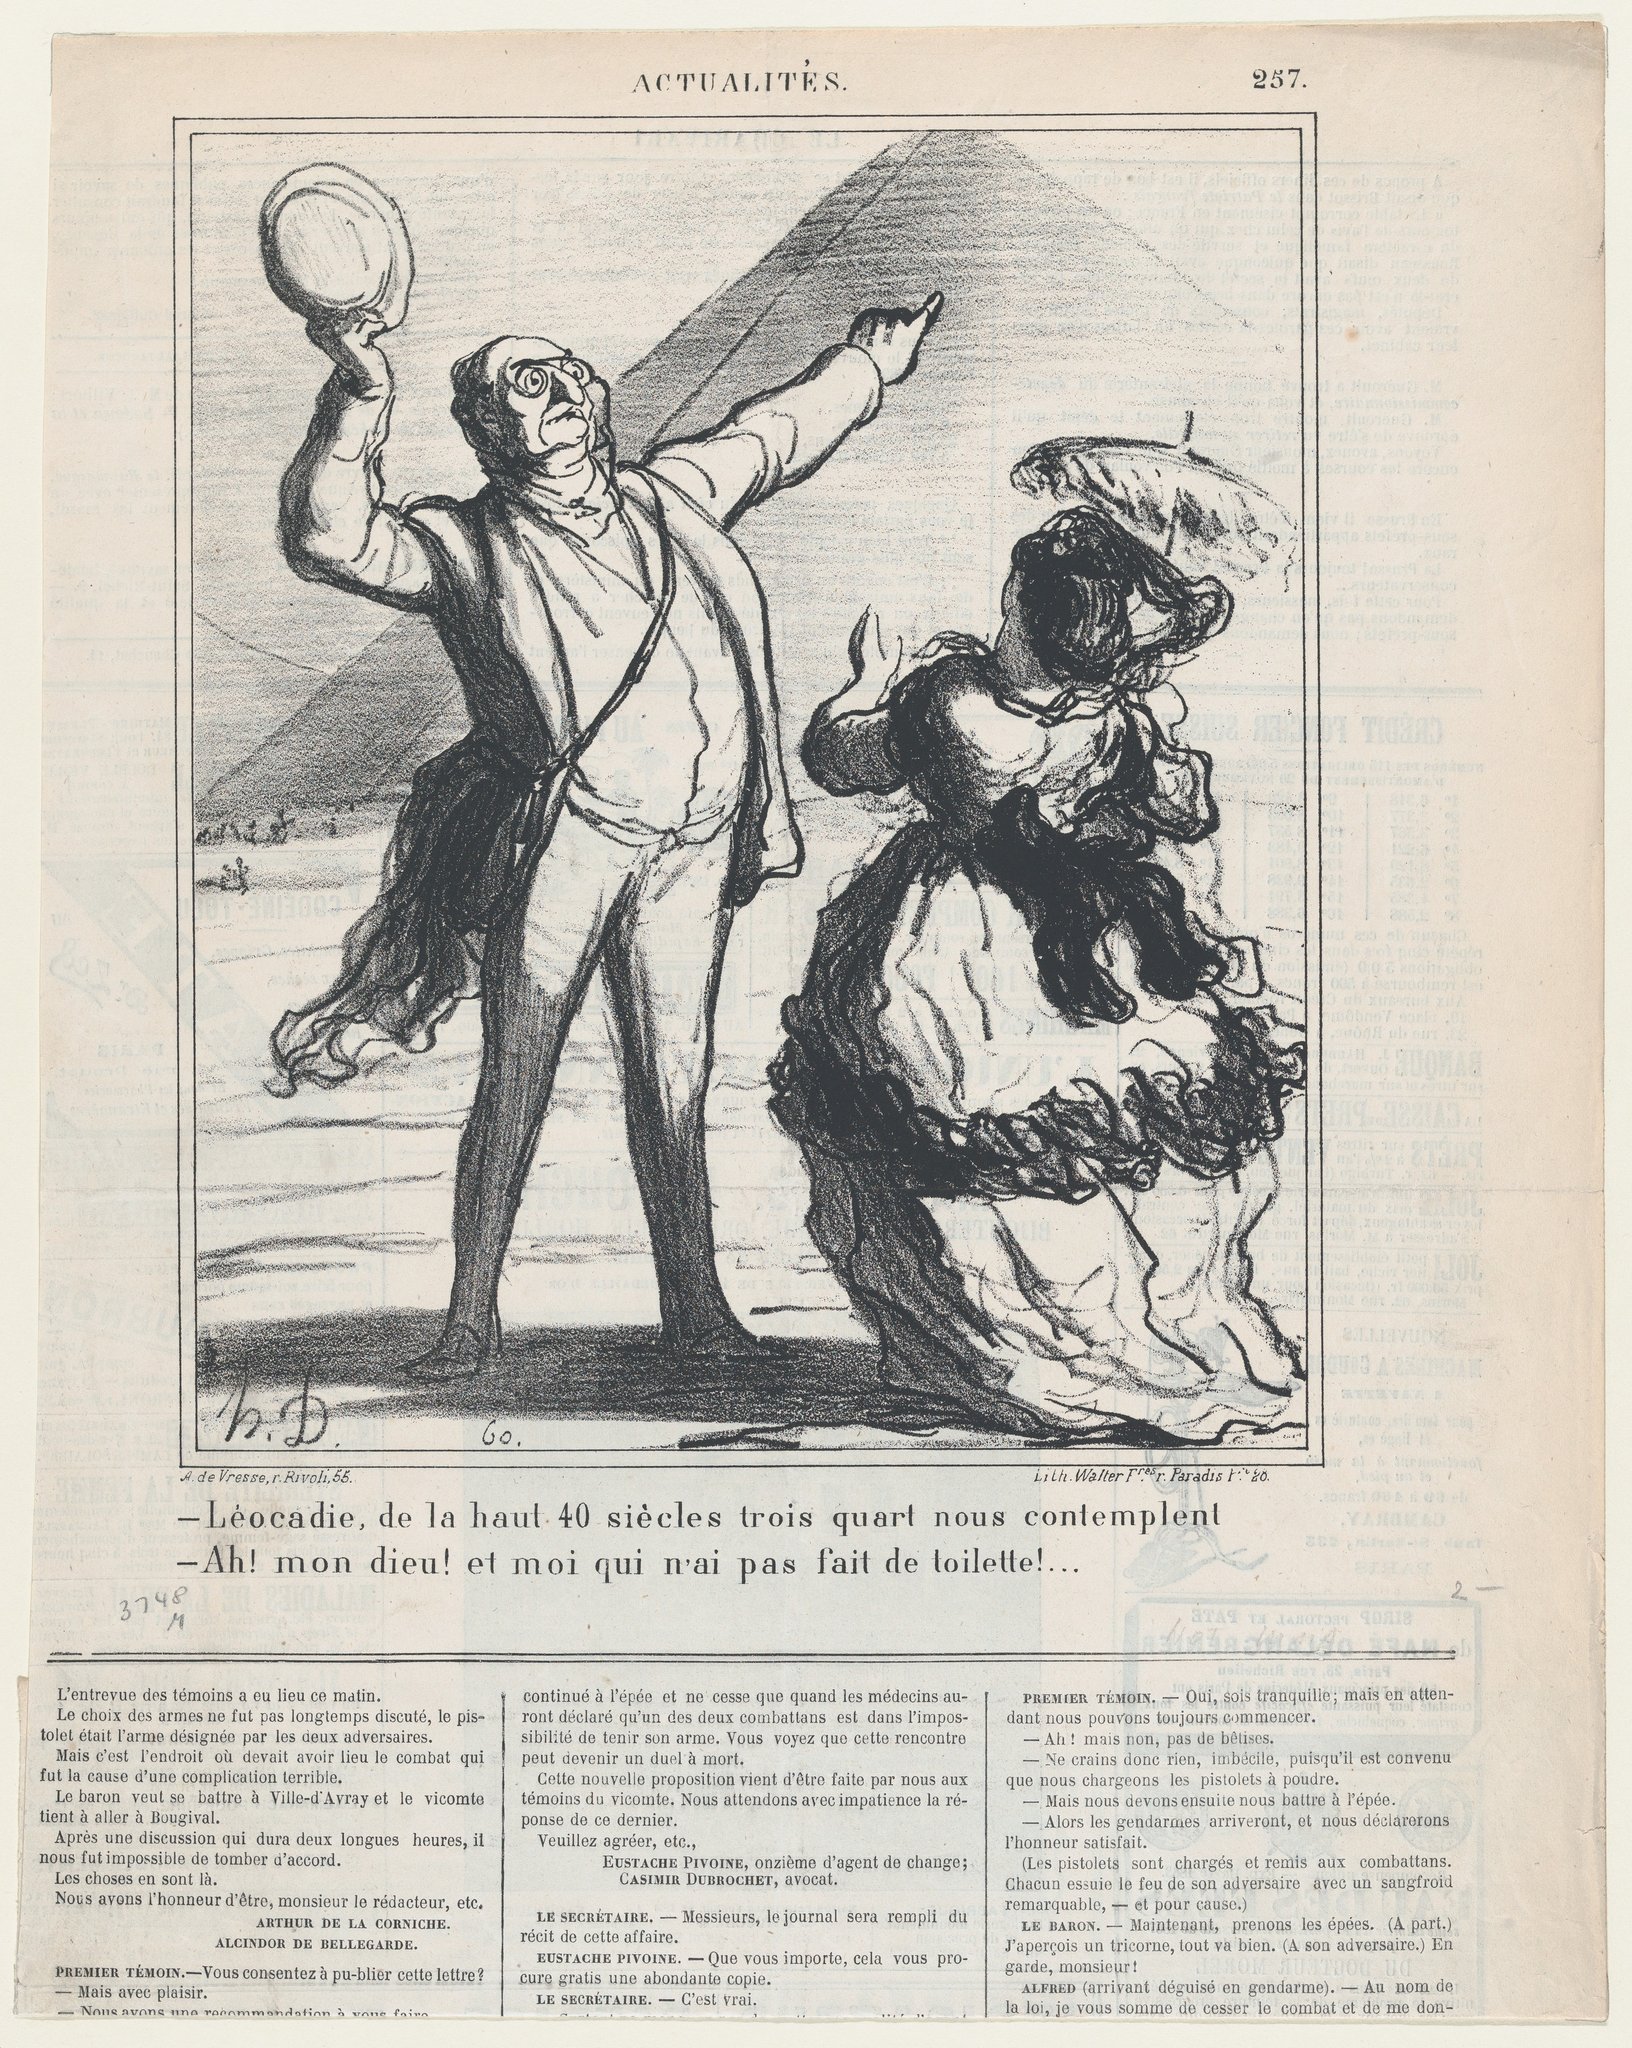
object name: print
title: –Léocadie, up there 40 centuries and three quarters are looming down upon us. –Oh, my God, and I didn't even dress up!…, from 'News of the day,' published in Le Charivari, November 27, 1869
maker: honoré daumier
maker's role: artist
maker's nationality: french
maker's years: 1808-1879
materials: paper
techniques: lithograph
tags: pyramids,men,women